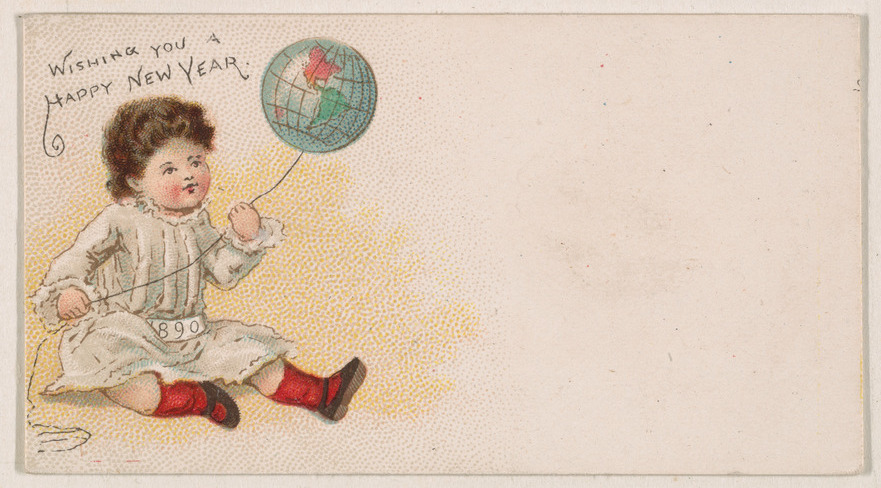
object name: print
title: Wishing You a Happy New Year, from the New Years 1890 series (N227) issued by Kinney Bros.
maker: kinney brothers tobacco company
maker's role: publisher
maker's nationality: american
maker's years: 1869-2011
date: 1889-1890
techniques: color lithograph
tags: children,balloons,globes